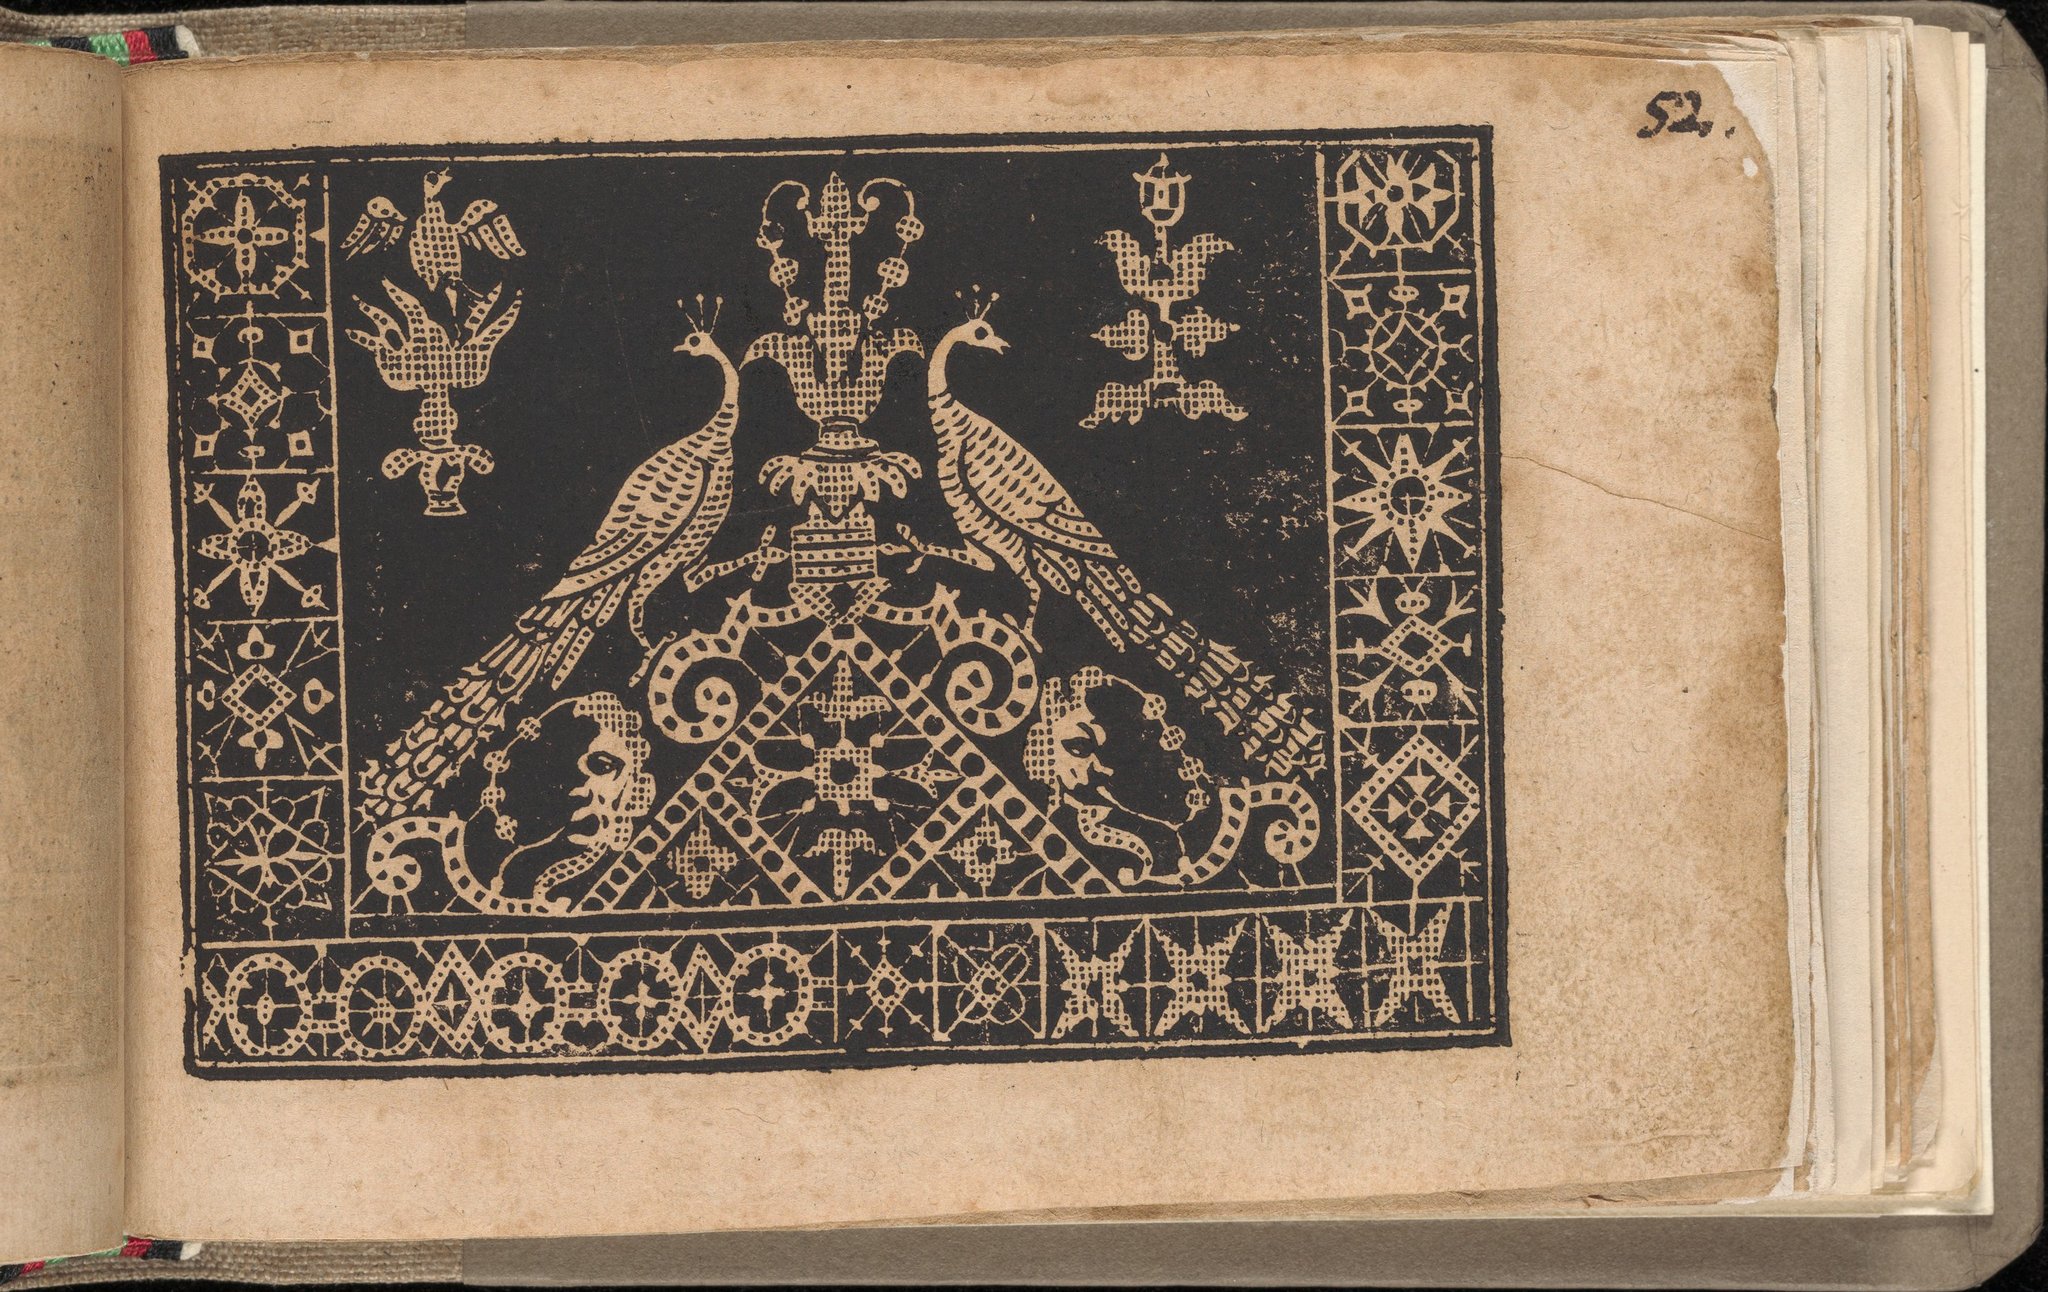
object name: book print ornament architecture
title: Schön newes Modelbuch (Page 52r)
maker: sigismundus latomus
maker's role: publisher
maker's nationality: german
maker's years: 1599-1632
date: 1608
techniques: woodcut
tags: ornament,peacocks